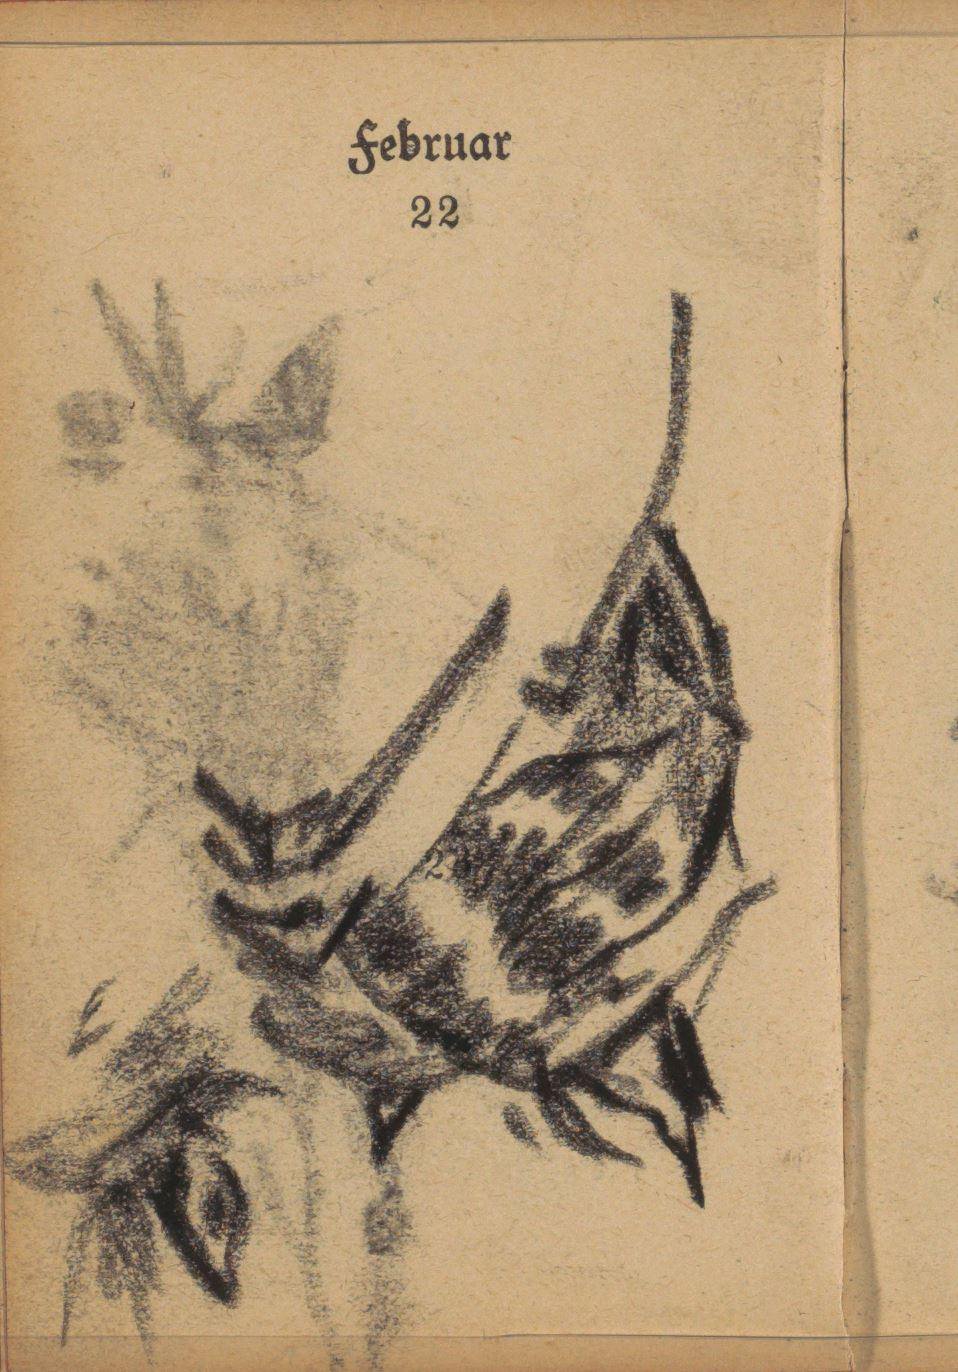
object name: sketchbook leaf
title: Paarden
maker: george hendrik breitner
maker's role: draughtsman, painter, print maker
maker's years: 1857-1923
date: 1893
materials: chalk, paper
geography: amsterdam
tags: horse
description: Pagina 31 uit een als schetsboek gebruikte agenda met 80 bladen.